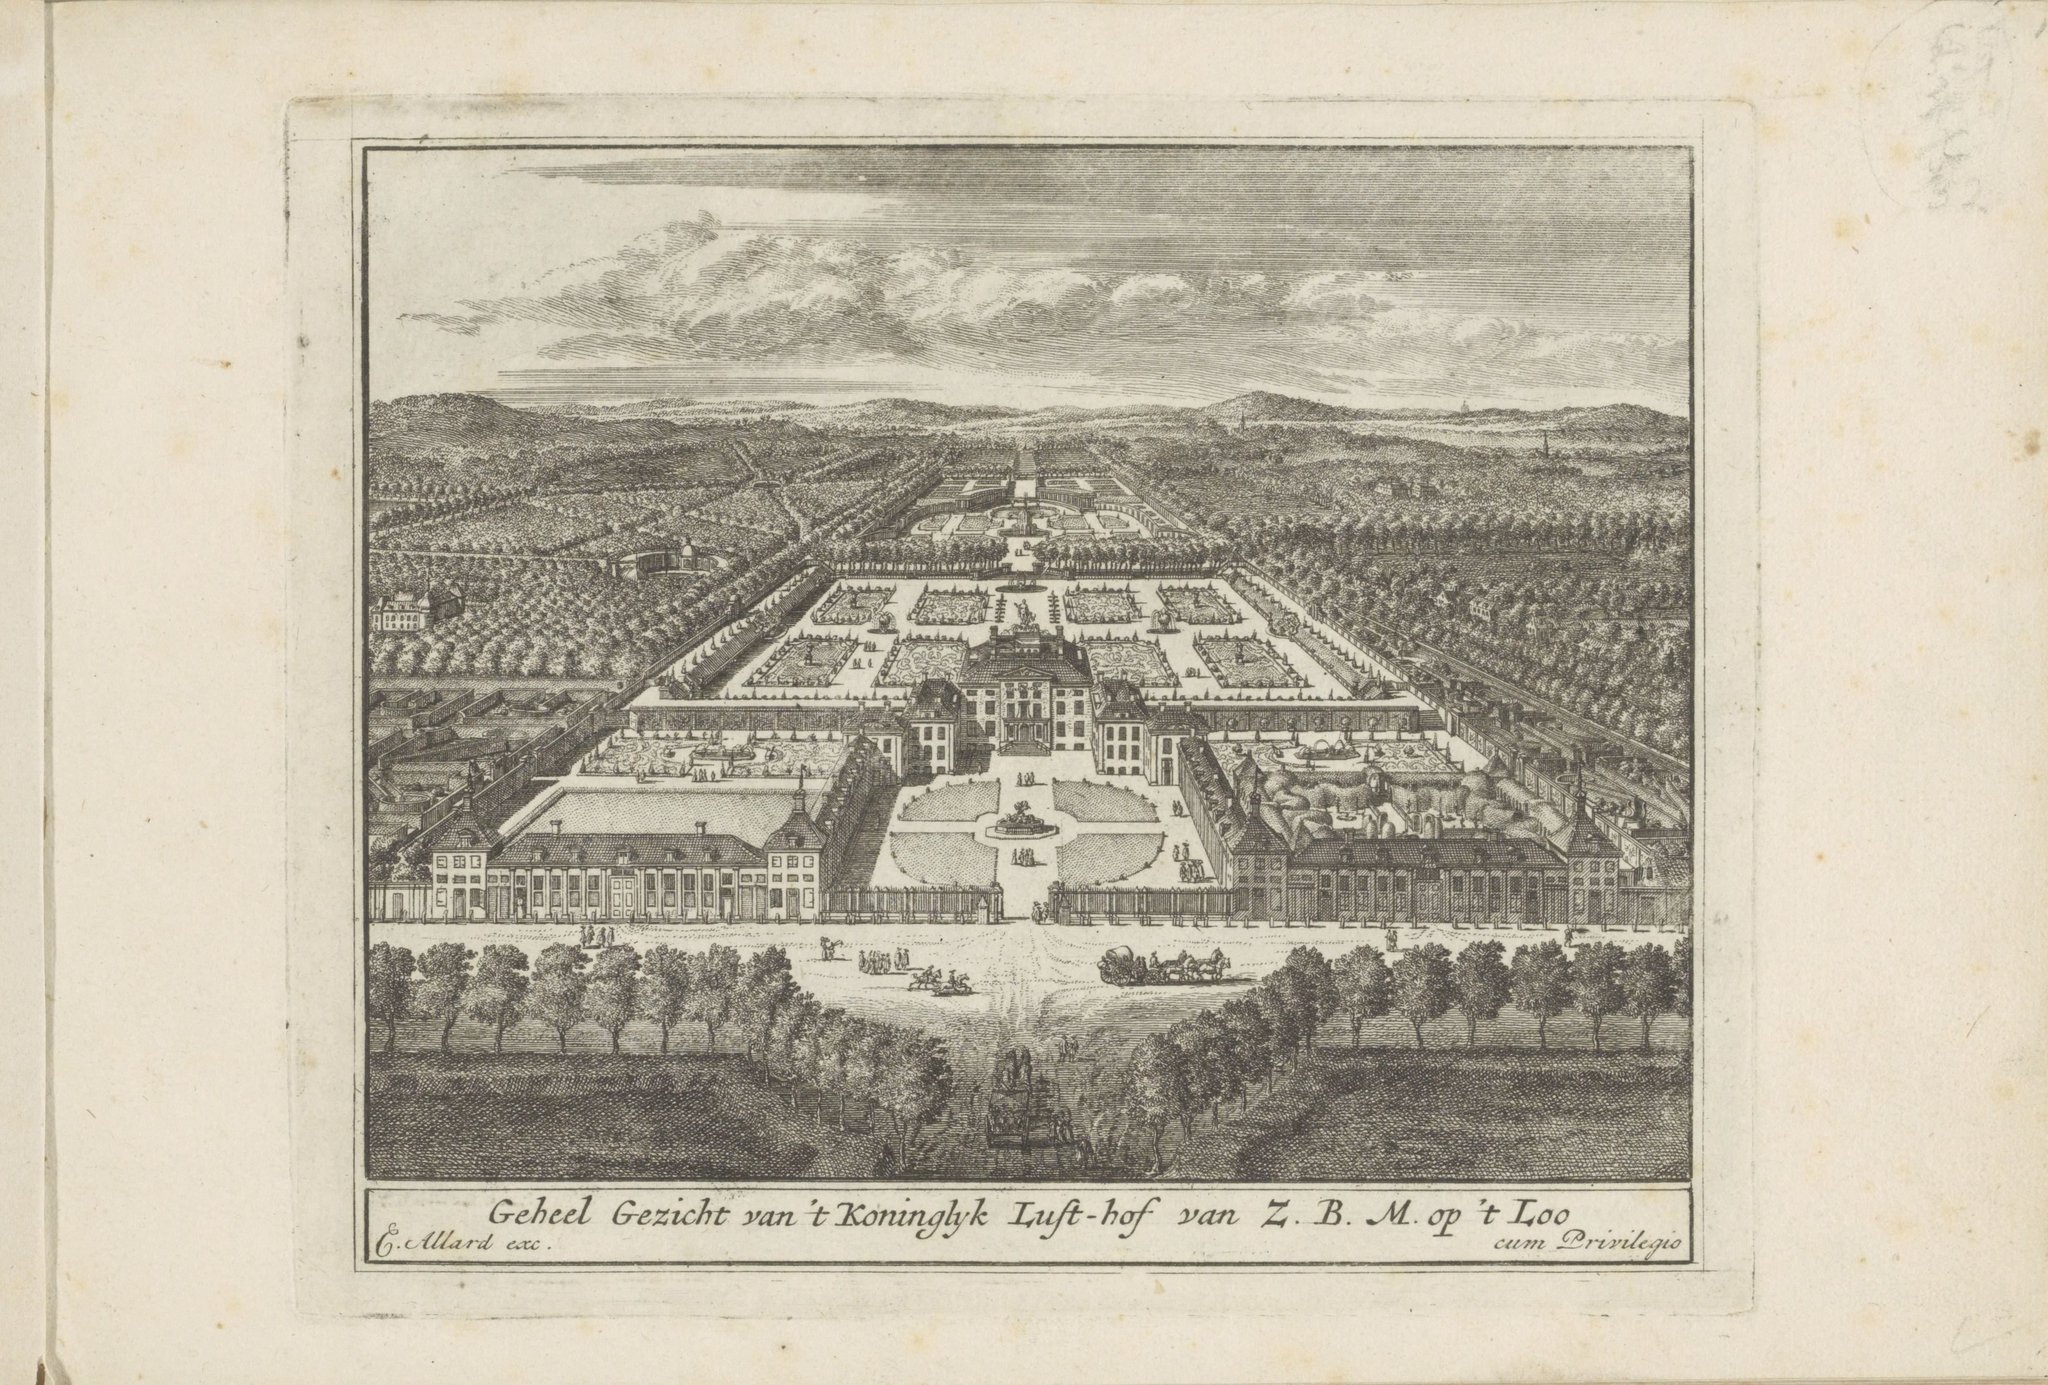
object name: album leaf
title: Geheel Gezicht van 't Koninglyk Lust-hof van Z.B. M. op 't Loo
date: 1689-1701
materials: paper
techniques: etching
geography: amsterdam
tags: palace, french or architectonic garden; formal garden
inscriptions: inscription: ‘1913 z inv’, collector's mark: Lugt 2166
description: Gezicht op Paleis Het Loo en de bijbehorende tuinen in vogelvluchtperspectief. Prent maakt deel uit van een album.